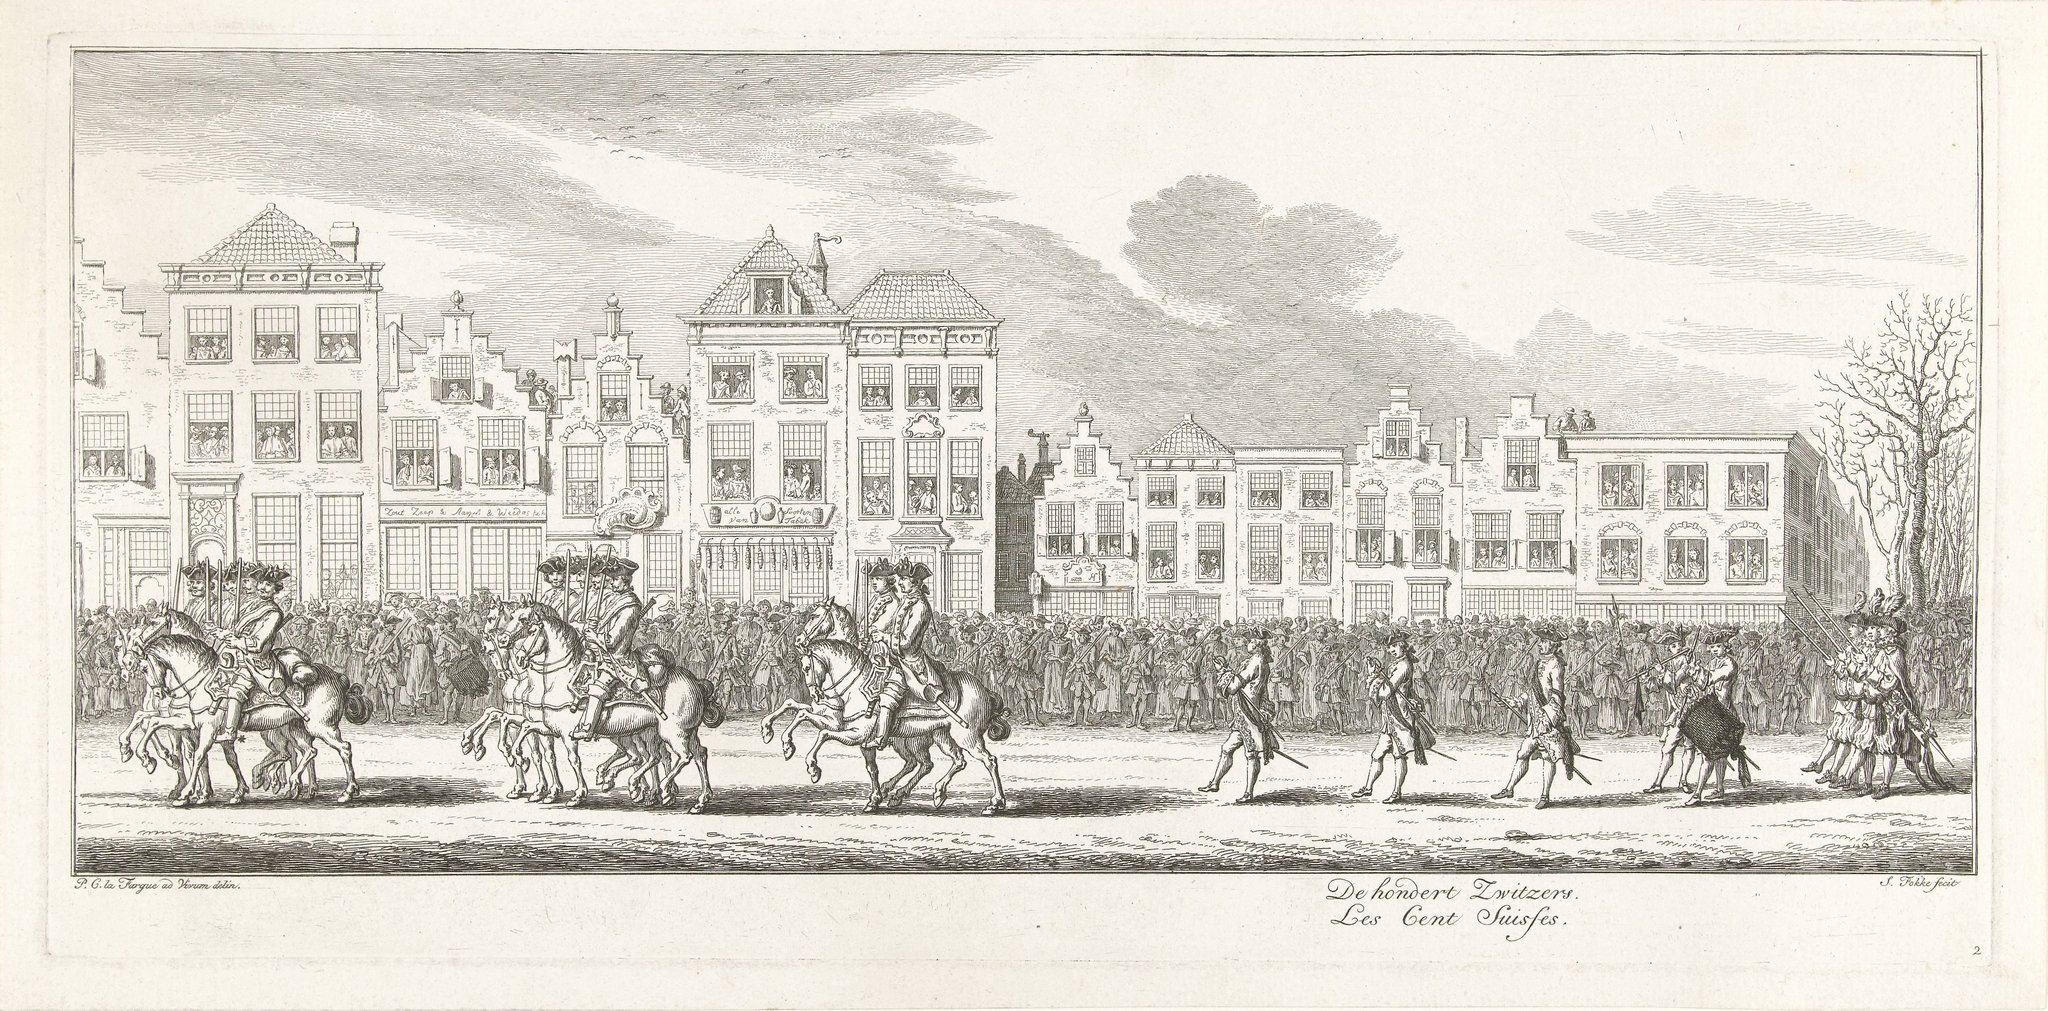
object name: print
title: Lijkstoet van prinses Anna van Hannover te Delft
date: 1759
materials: paper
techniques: engraving, etching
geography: northern netherlands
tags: the hague, anna van hannover, cortege, funeral procession, delft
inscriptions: collector's mark: Lugt 2228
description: De Cent-Suisses. Onderdeel van een serie van 16 platen plus een gedrukte beschrijving van de lijkstatie van de op 23 februari 1759 te Delft begraven prinses Anna van Hannover. Genummerd rechtsonder: 2.